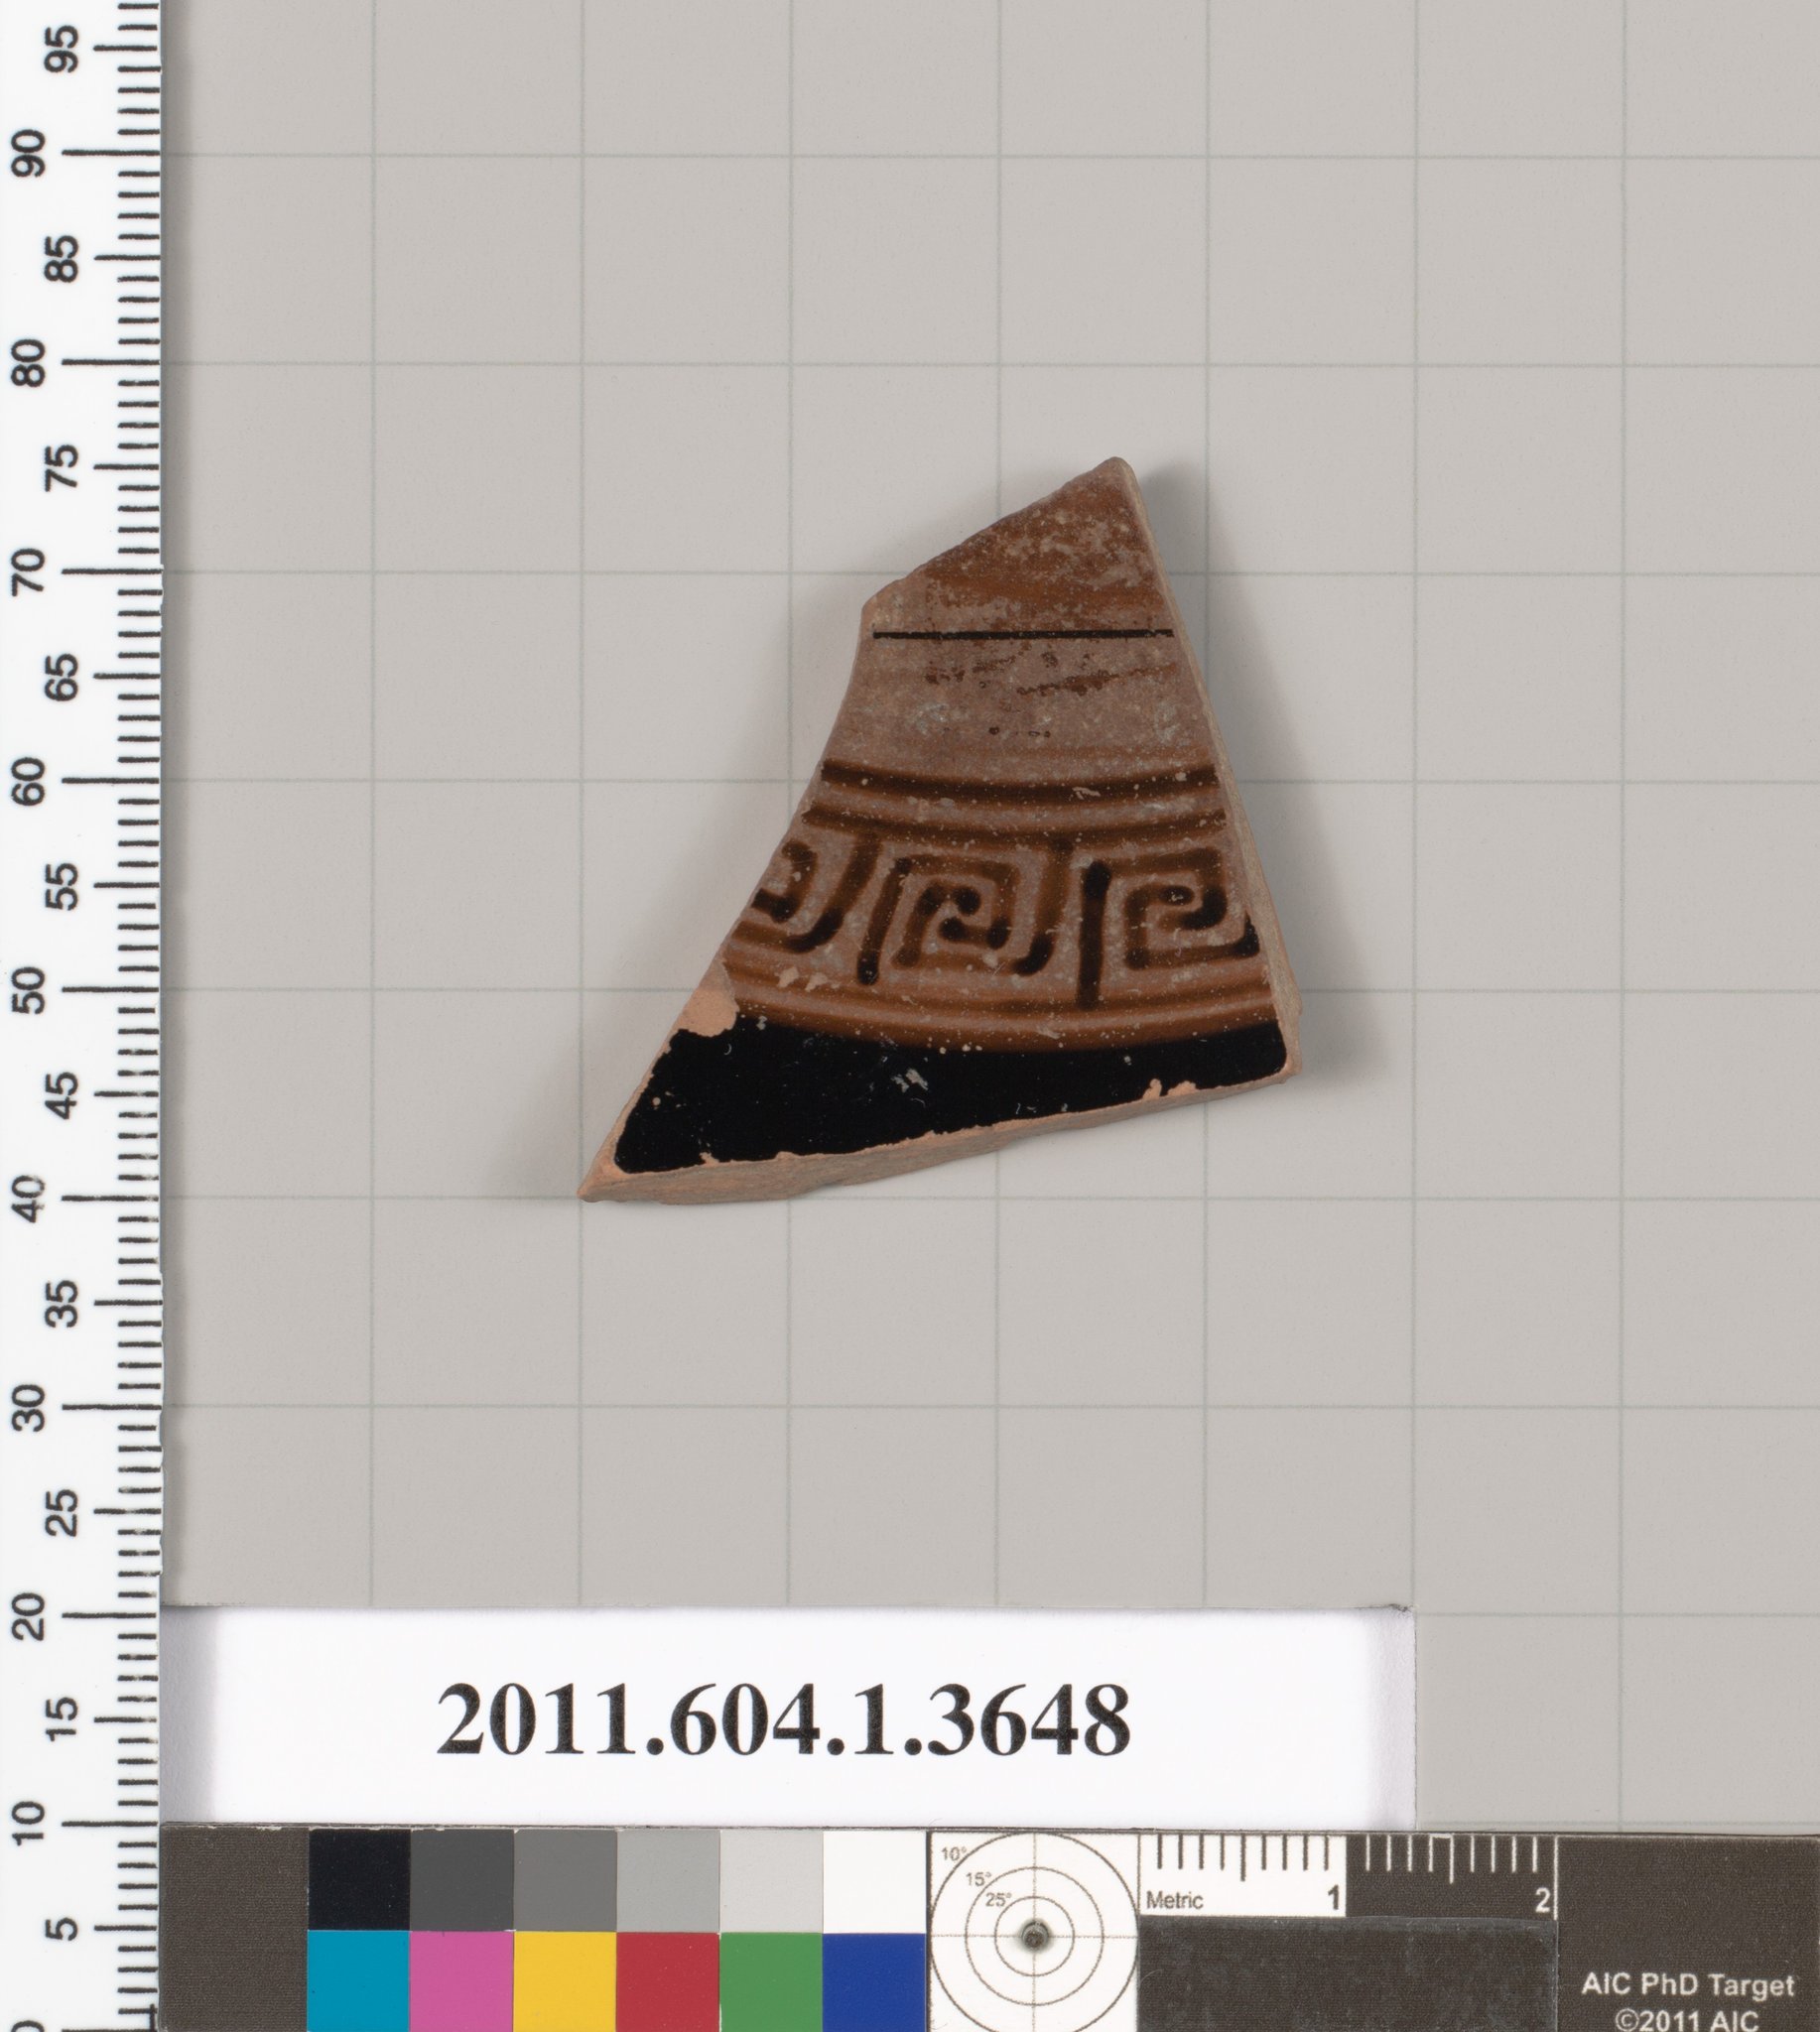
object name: kylix fragment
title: Terracotta fragment of a kylix (drinking cup)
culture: greek, attic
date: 500-476 BCE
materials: terracotta